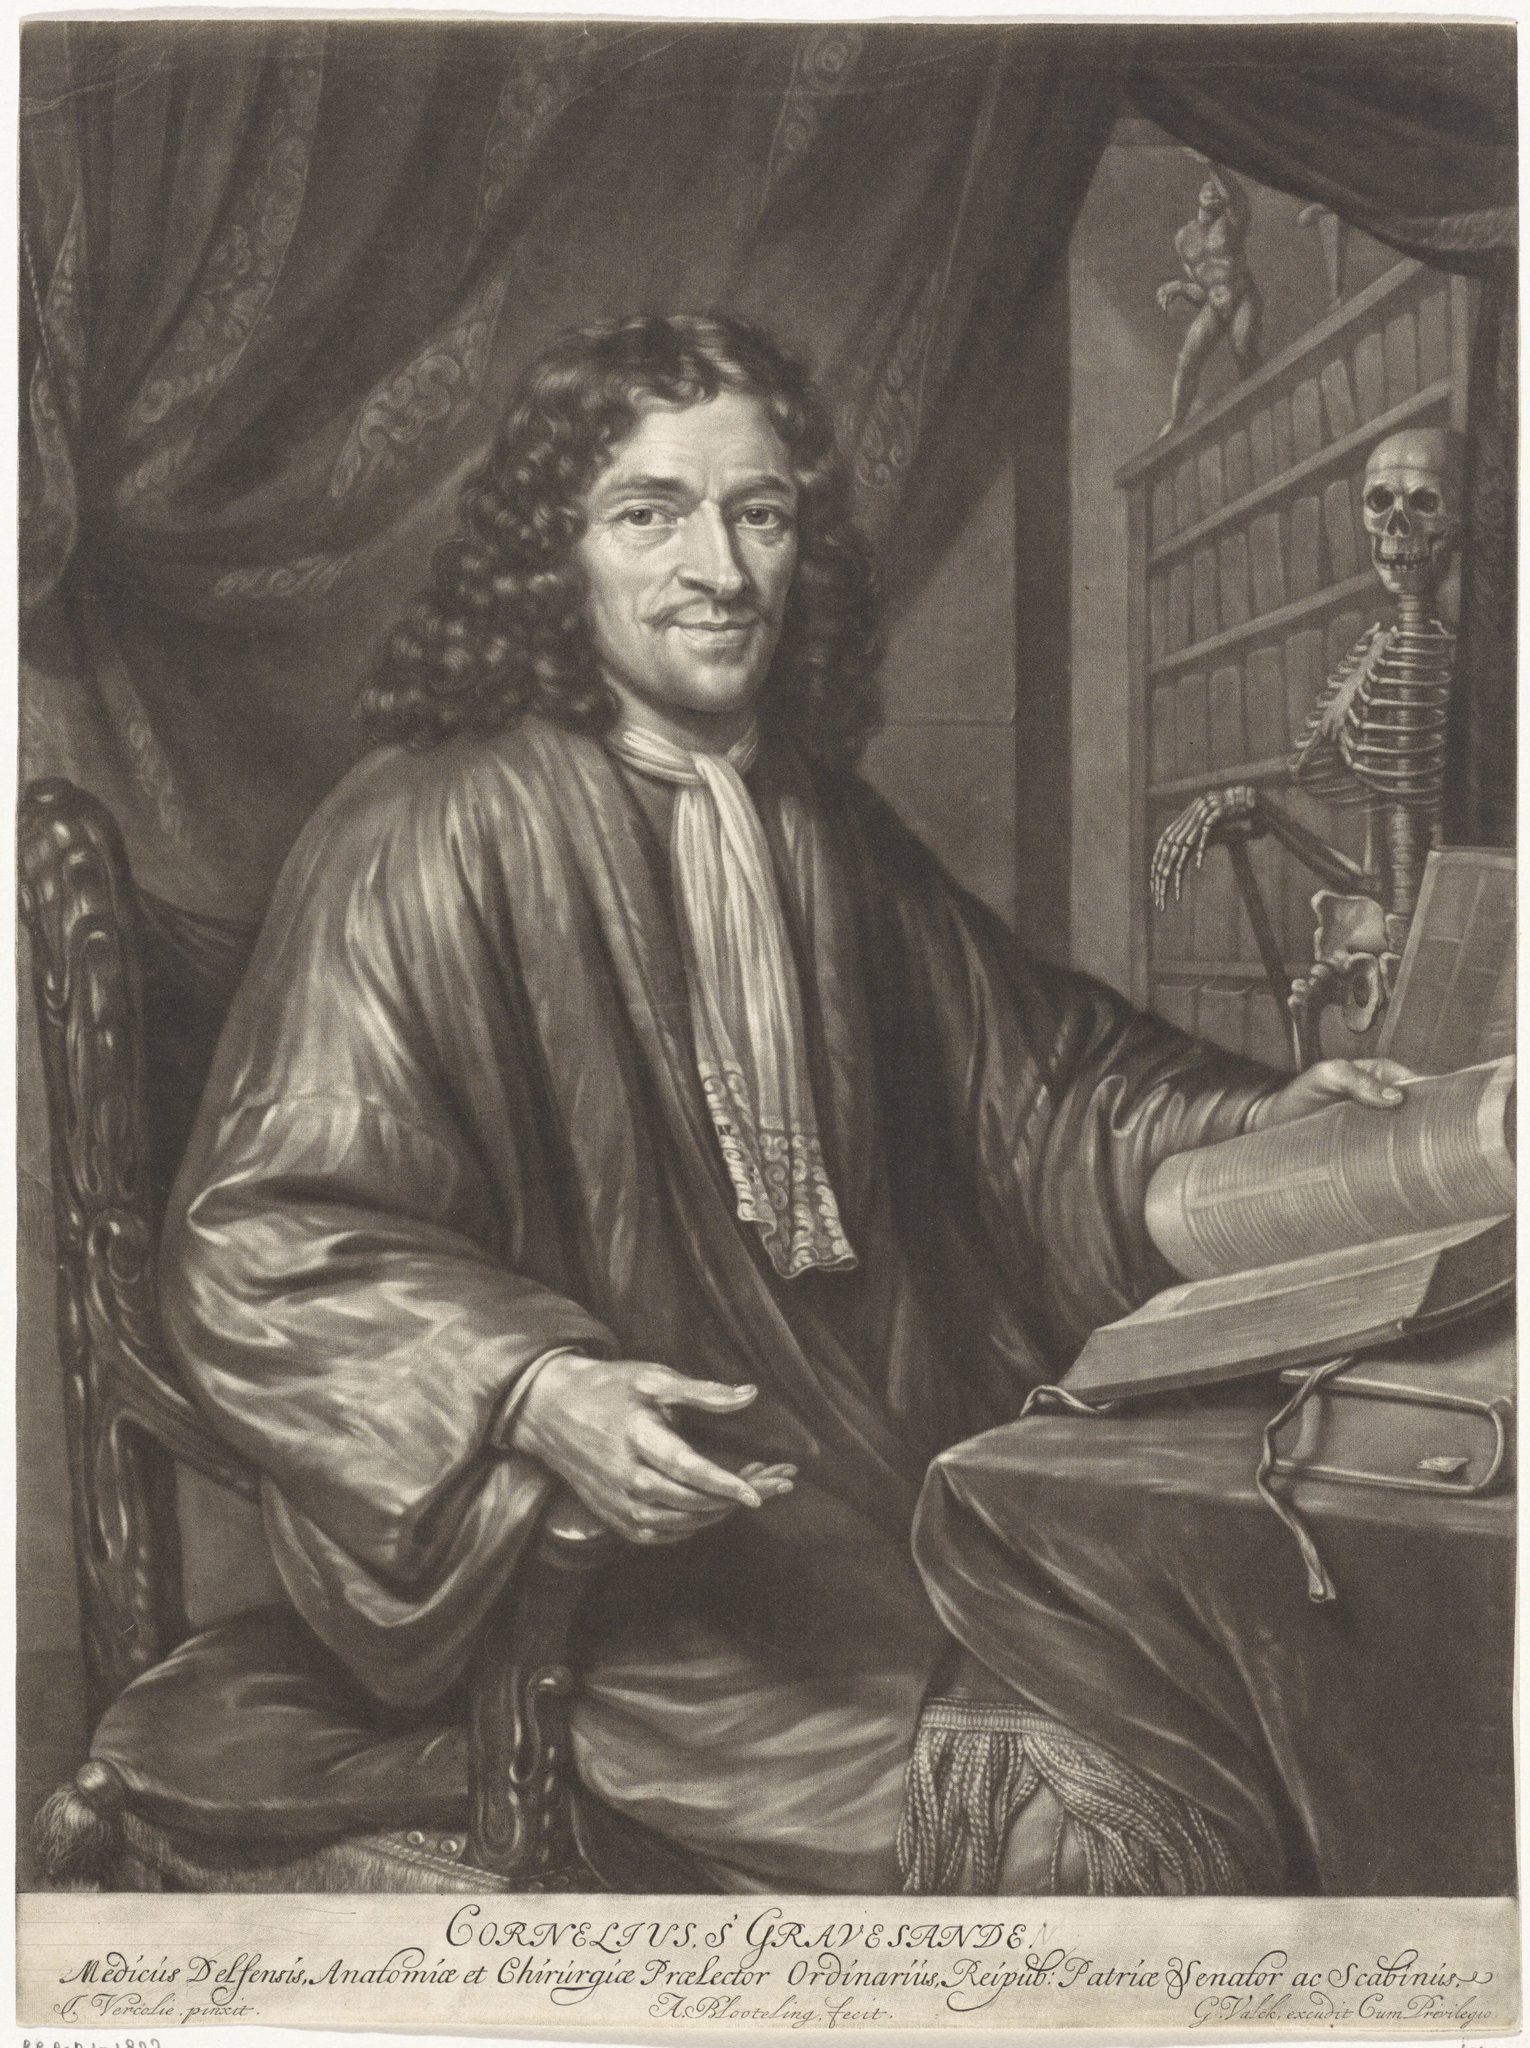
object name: print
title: Portret van Cornelius 's-Gravesande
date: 1660-1690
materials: paper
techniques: engraving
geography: amsterdam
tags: delft, writing-table, writing-desk, aspects of science in general (+ in workshop, laboratory), (human) skeleton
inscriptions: collector's mark: Lugt 240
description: Portret van Cornelius 's-Gravesande, medicus te Delft. Hij zit in zijn studeerkamer aan een tafel met boeken. Op de achtergrond een boekenkast en een menselijk skelet.